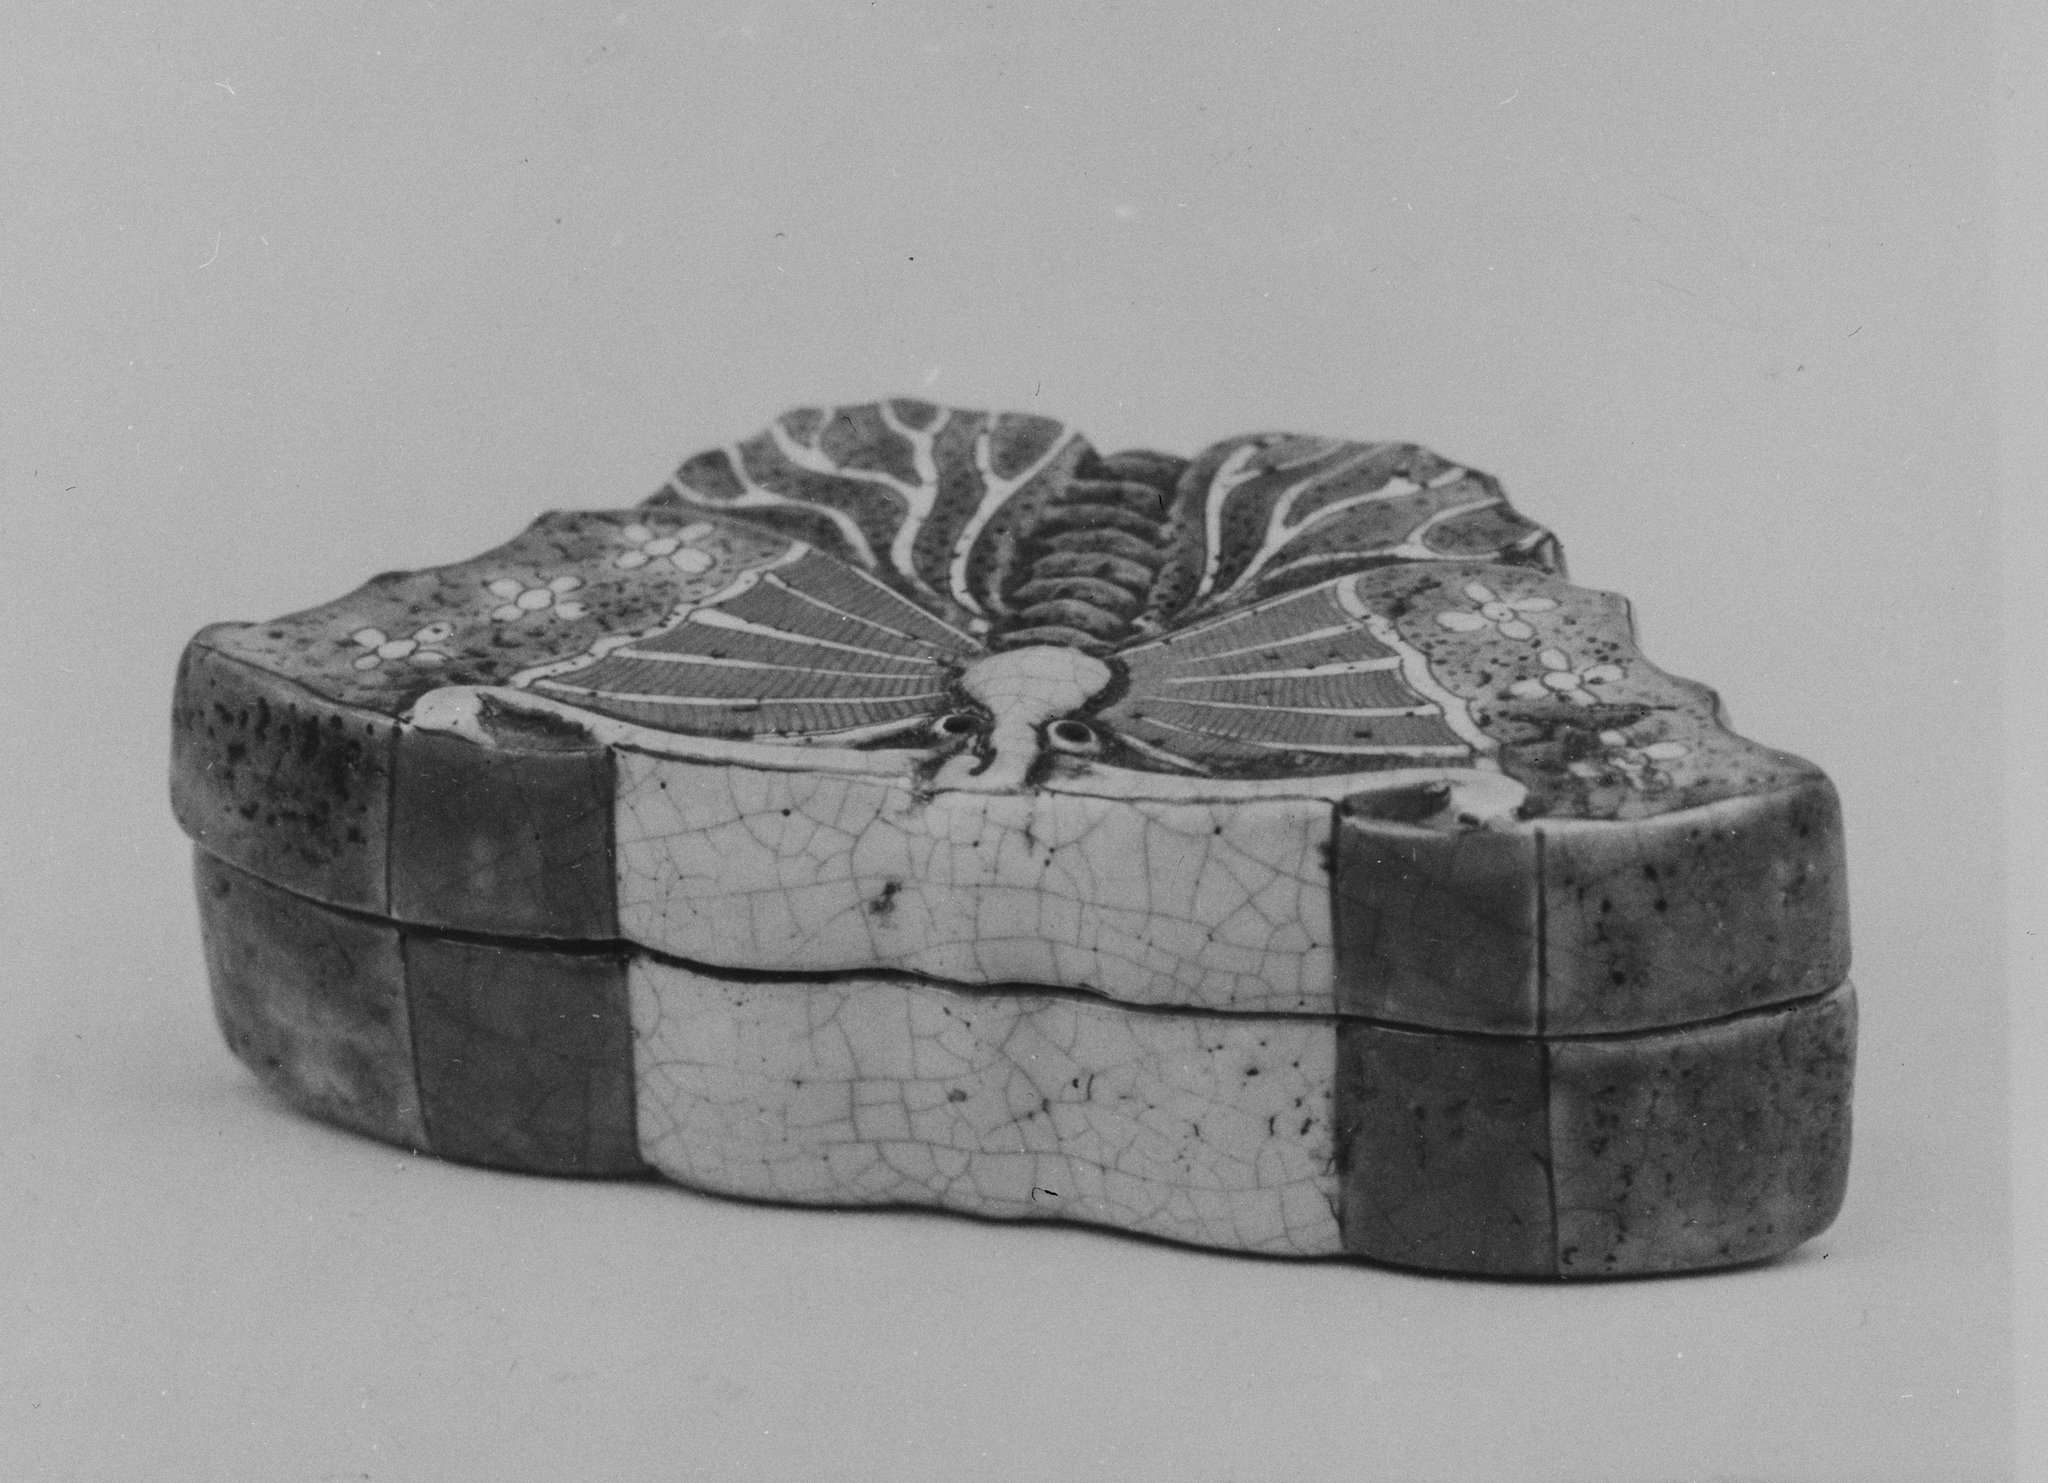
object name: covered incense box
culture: japanese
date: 1860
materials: enamel, faience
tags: butterflies